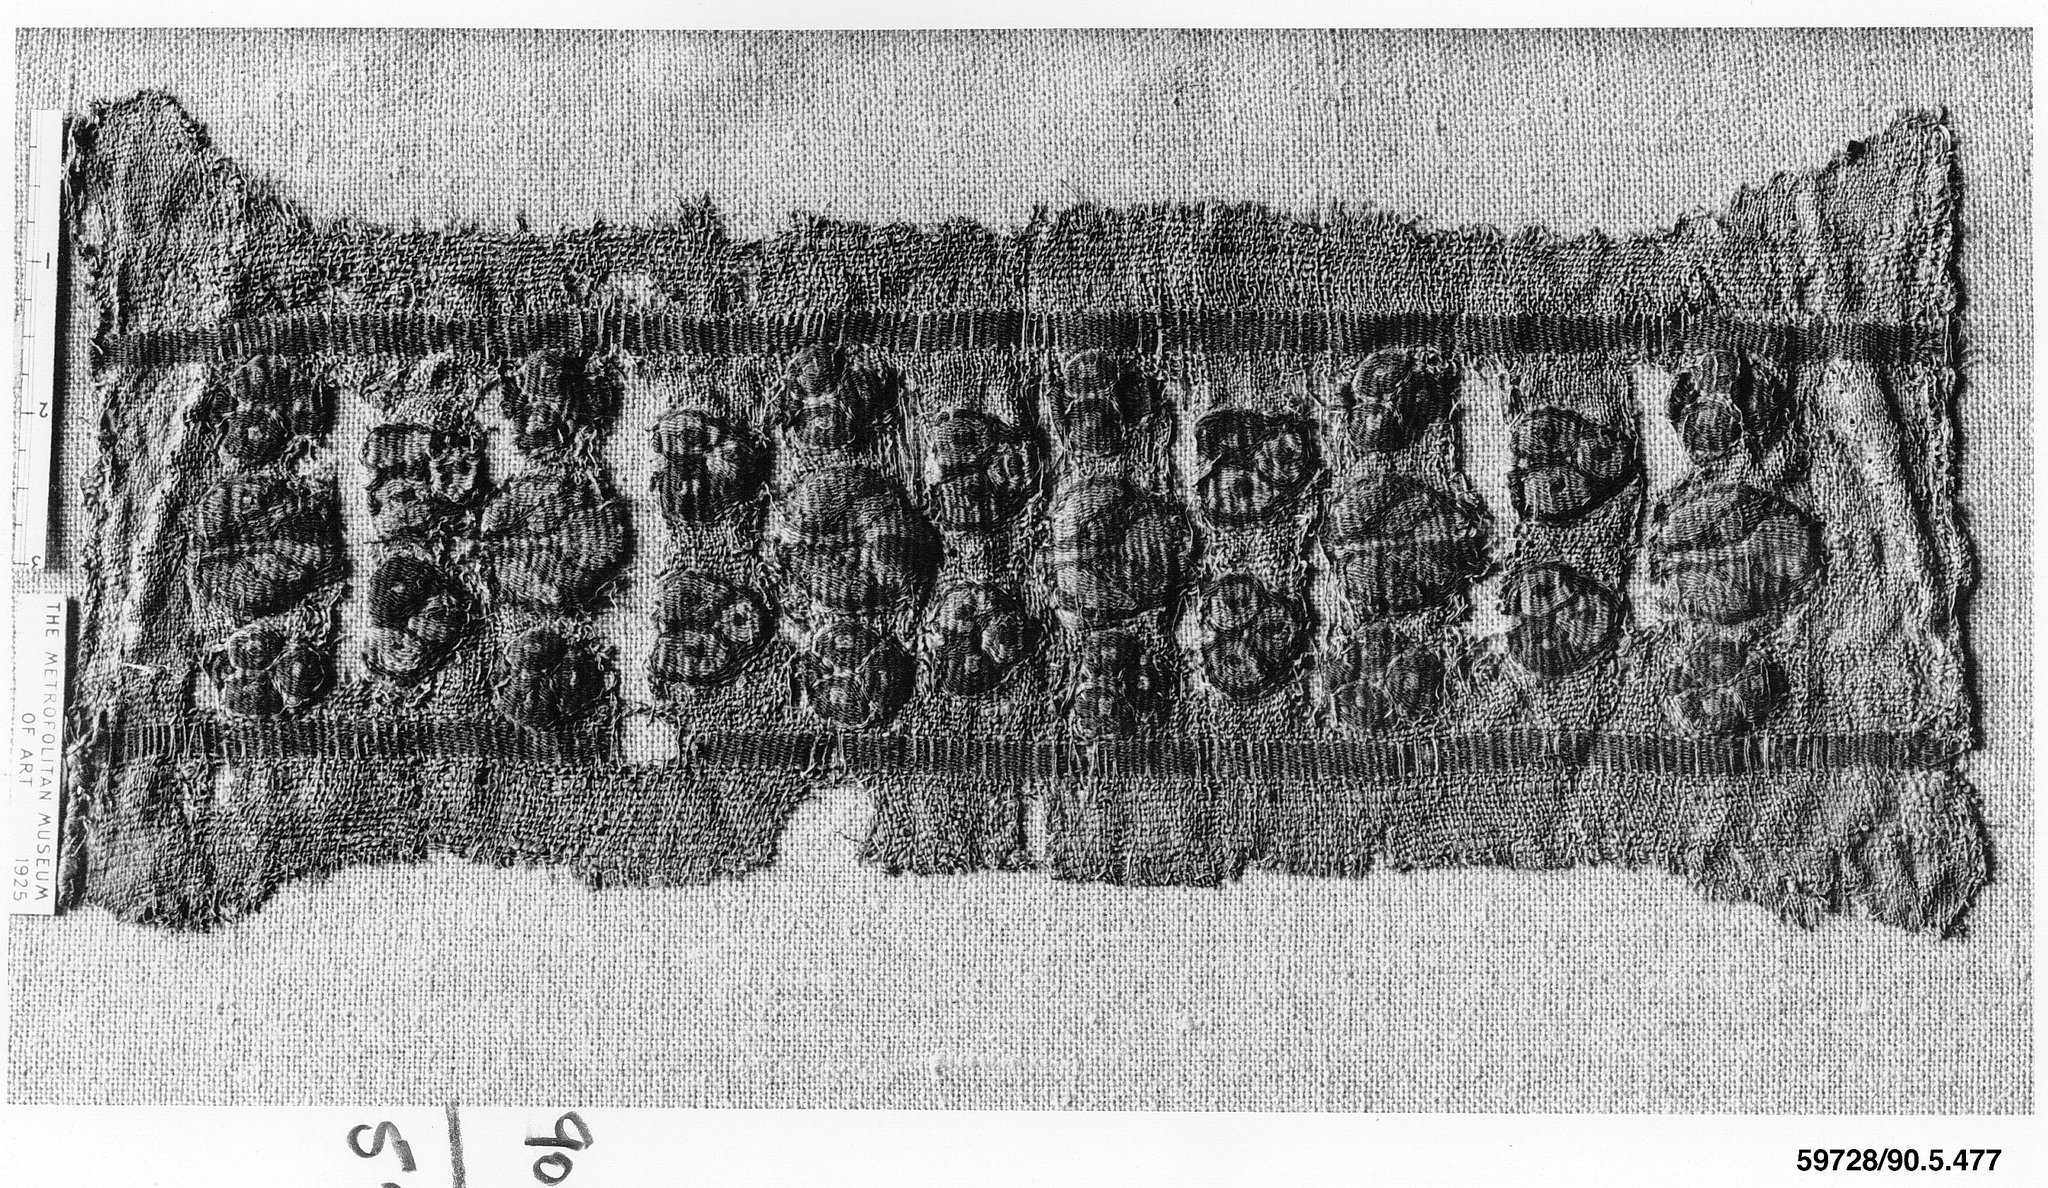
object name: textile fragment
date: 401-500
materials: linen, wool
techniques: weave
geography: egypt